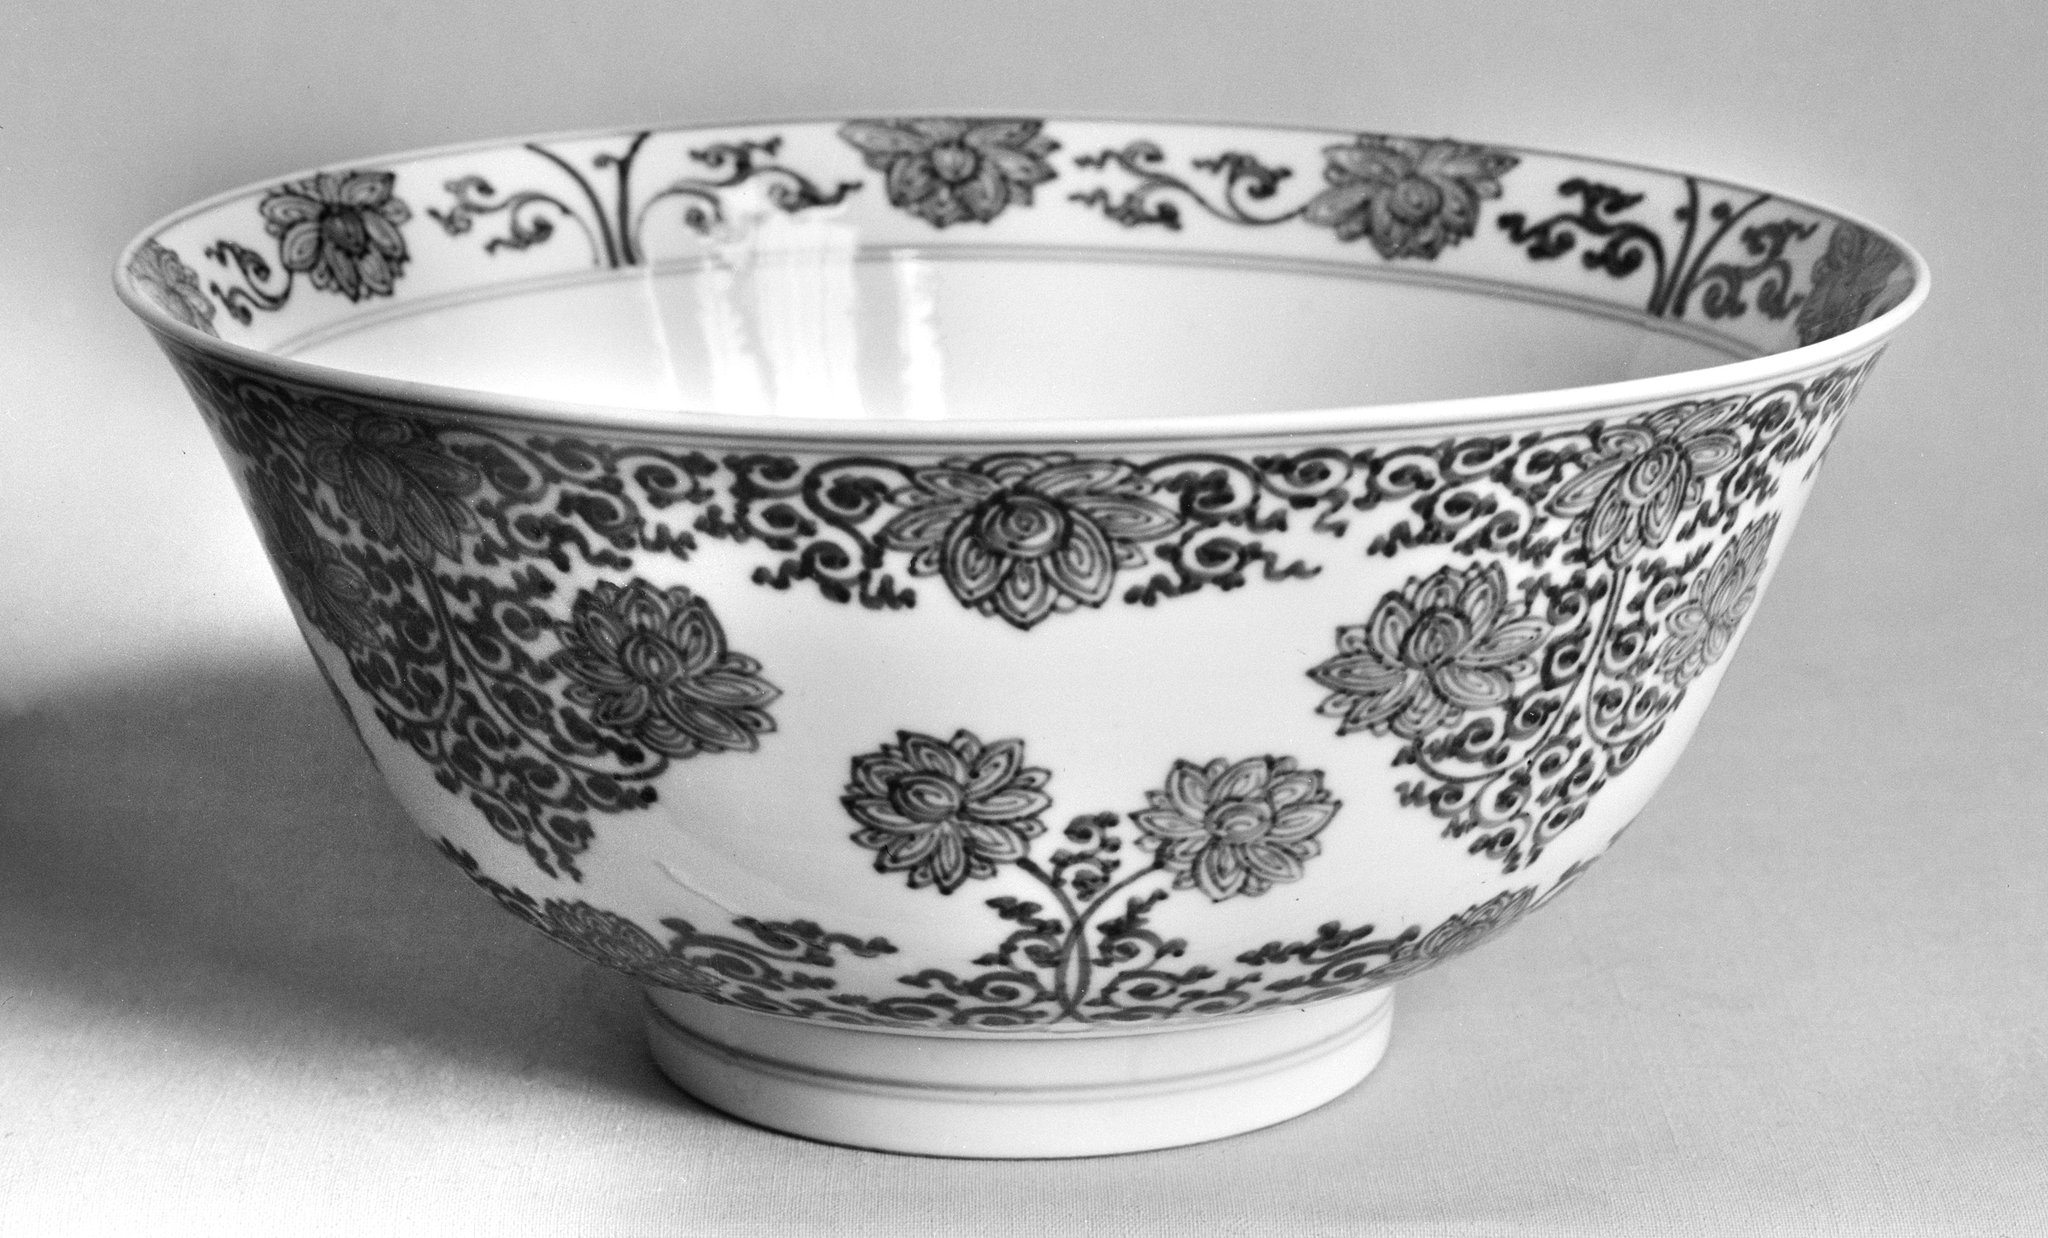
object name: bowl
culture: chinese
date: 1662-1722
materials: porcelain